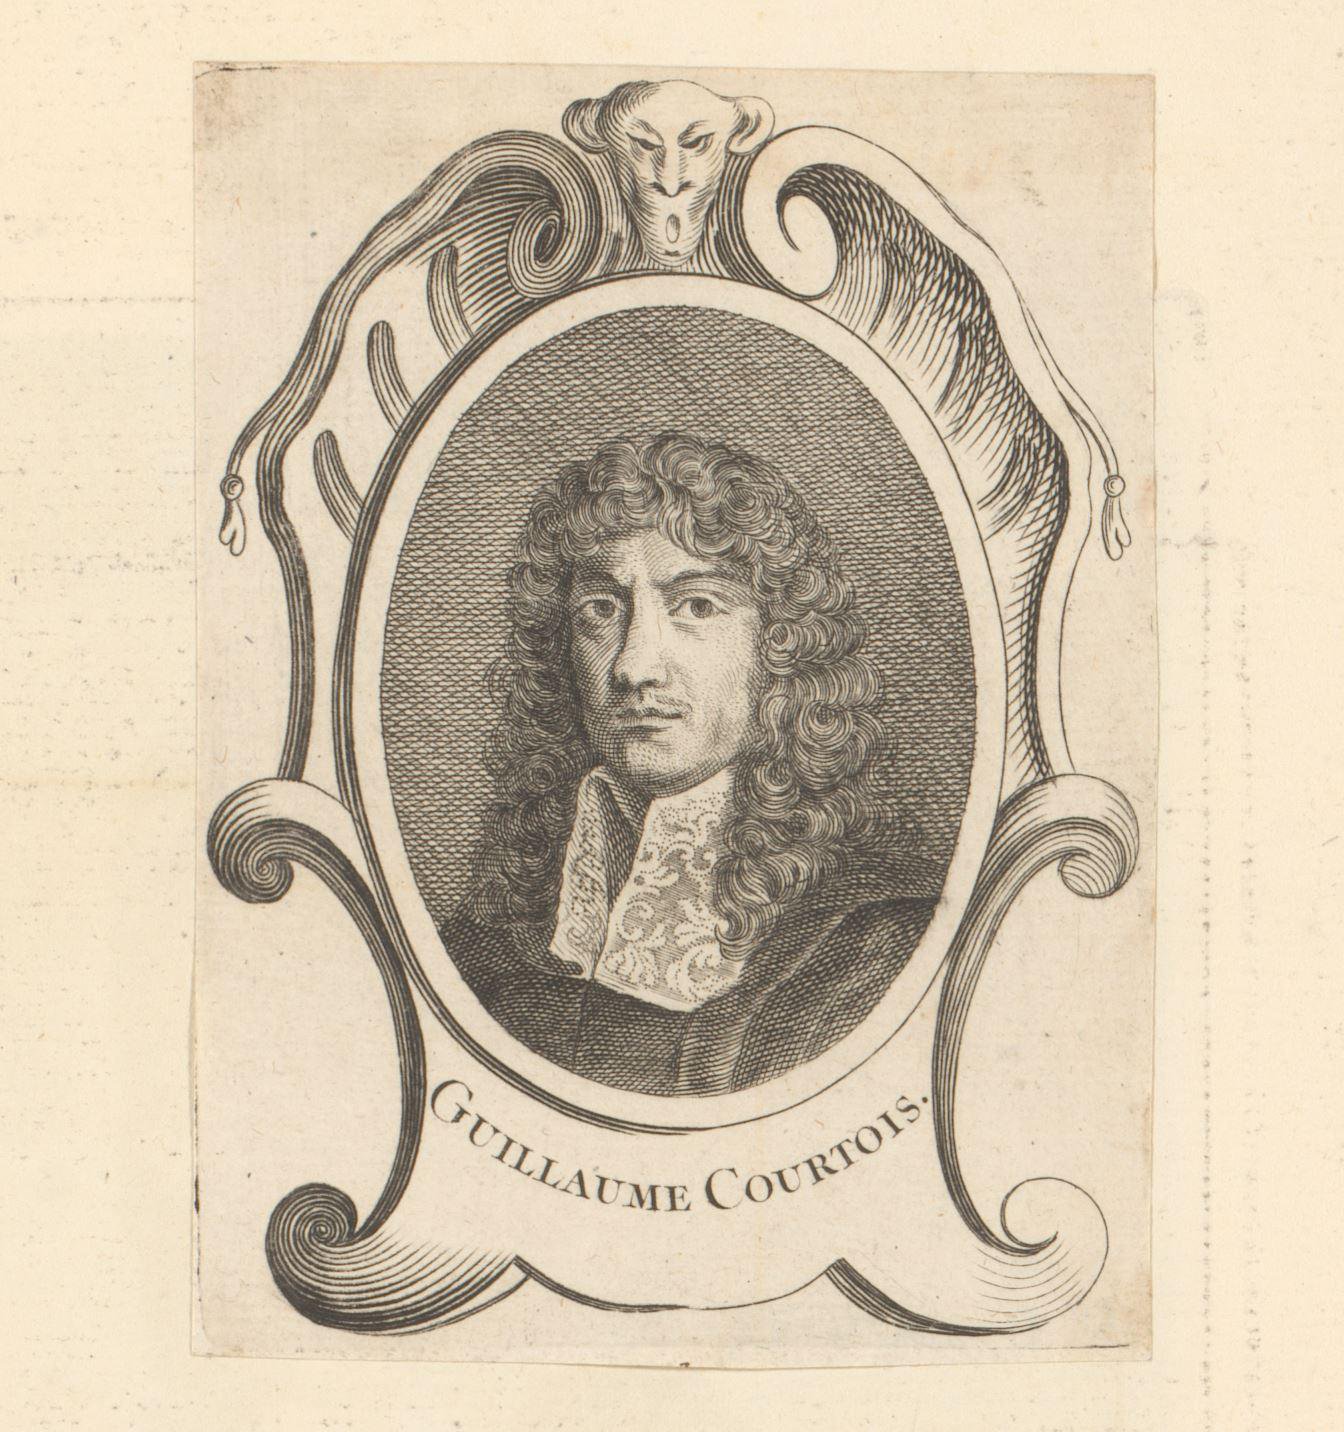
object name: album leaf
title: Portret van Jacques Courtois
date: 1745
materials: paper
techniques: engraving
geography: paris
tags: rome, painter, jacques courtois, historical persons, portrait, self-portrait of painter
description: Prent uit: Dézallier d'Argenville, Antoine Joseph. Abrégé de la vie des plus fameux peintres. 4 dln. Parijs: De Bure l'aîné, 1745, dl. 2, p. 321. De samensteller heeft deze prent in het album geplakt als illustratie bij: Pilkington, Matthew en Johann Heinrich Füssli. A dictionary of painters, from the revival of the art to the present period. 4 dln. Londen: John Crowder, 1805, dl. 1, p. 139.